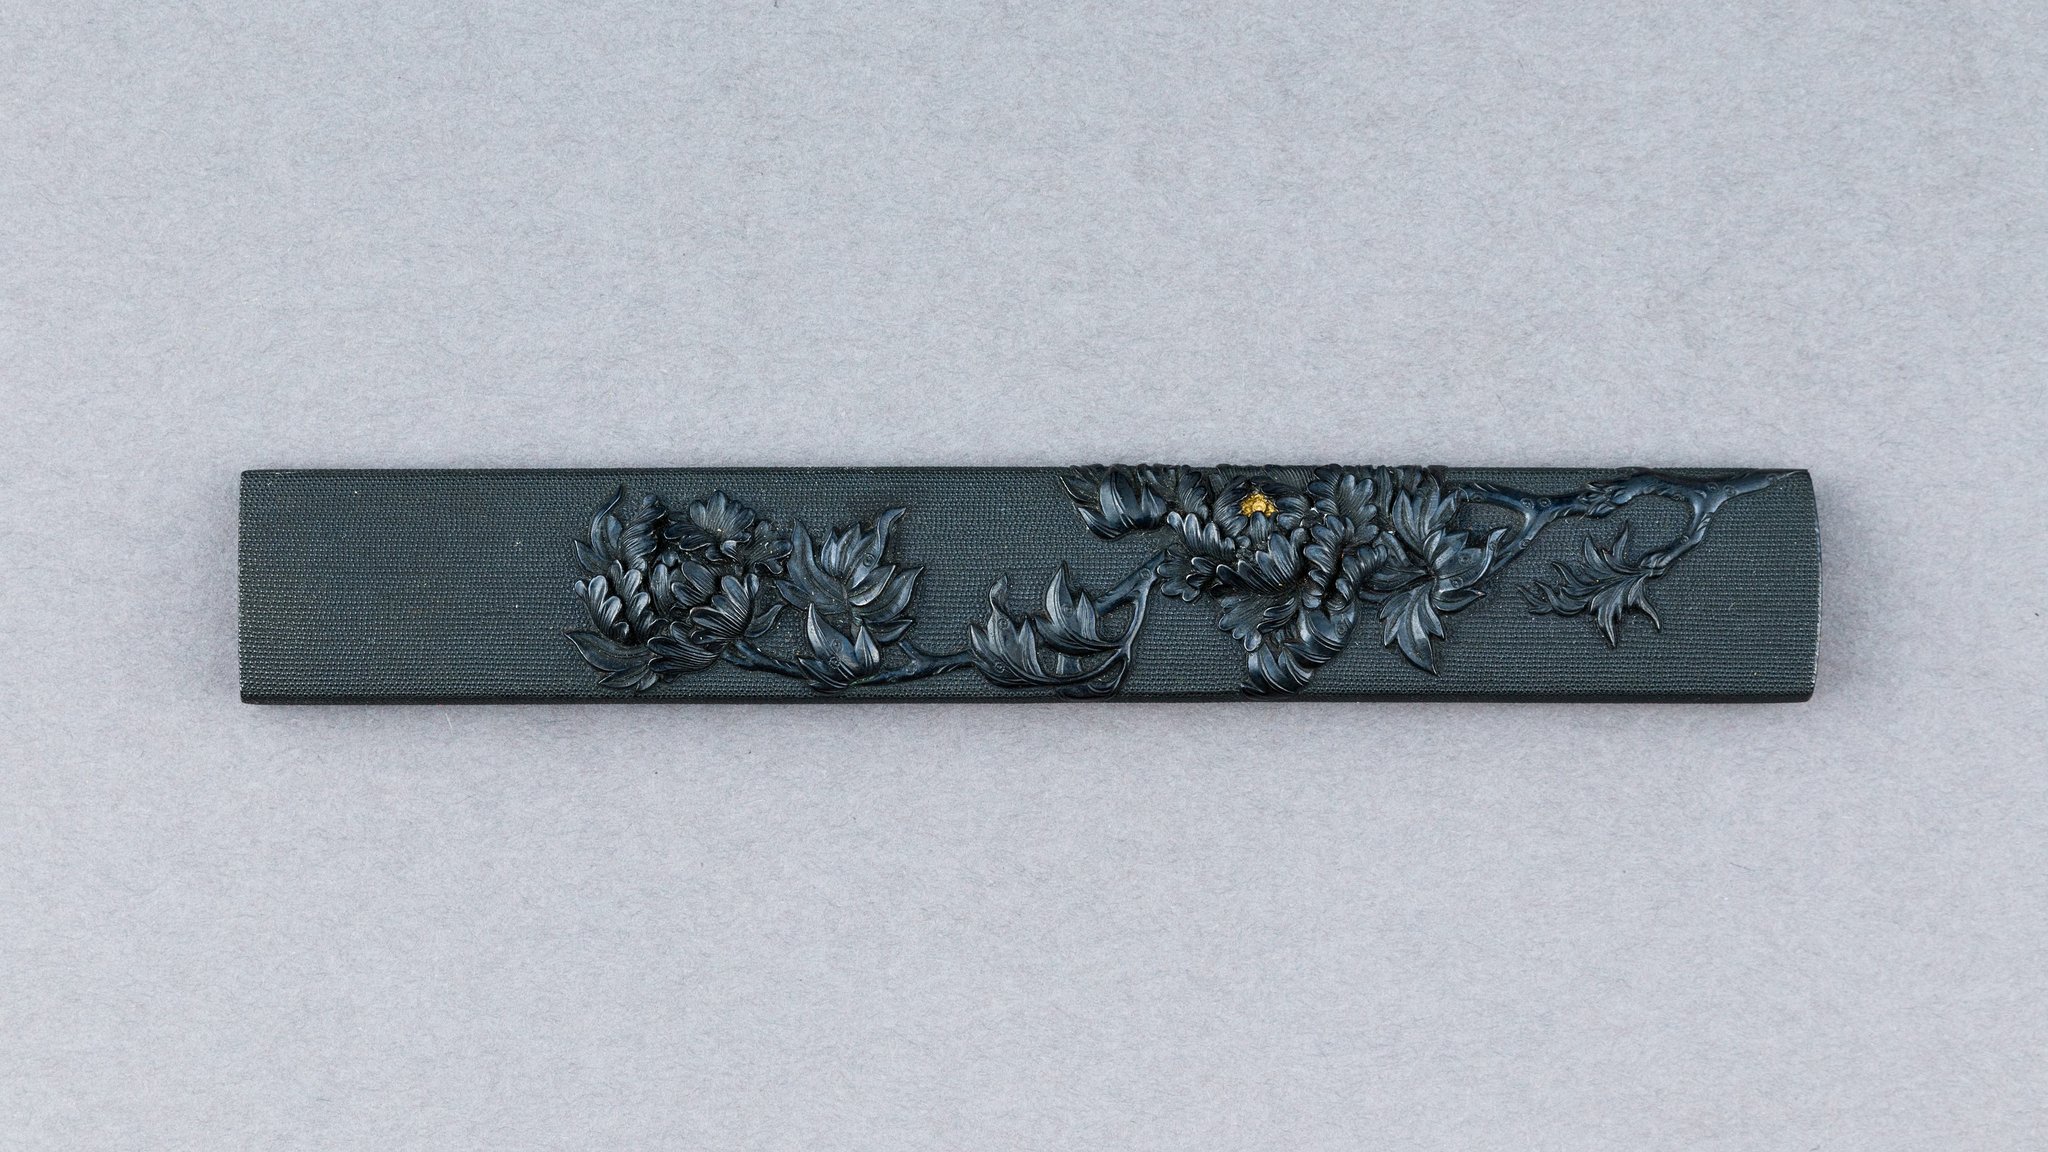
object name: knife handle kozuka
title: Knife Handle (Kozuka)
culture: japanese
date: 1615-1868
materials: gold alloy, gold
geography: japan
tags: plants